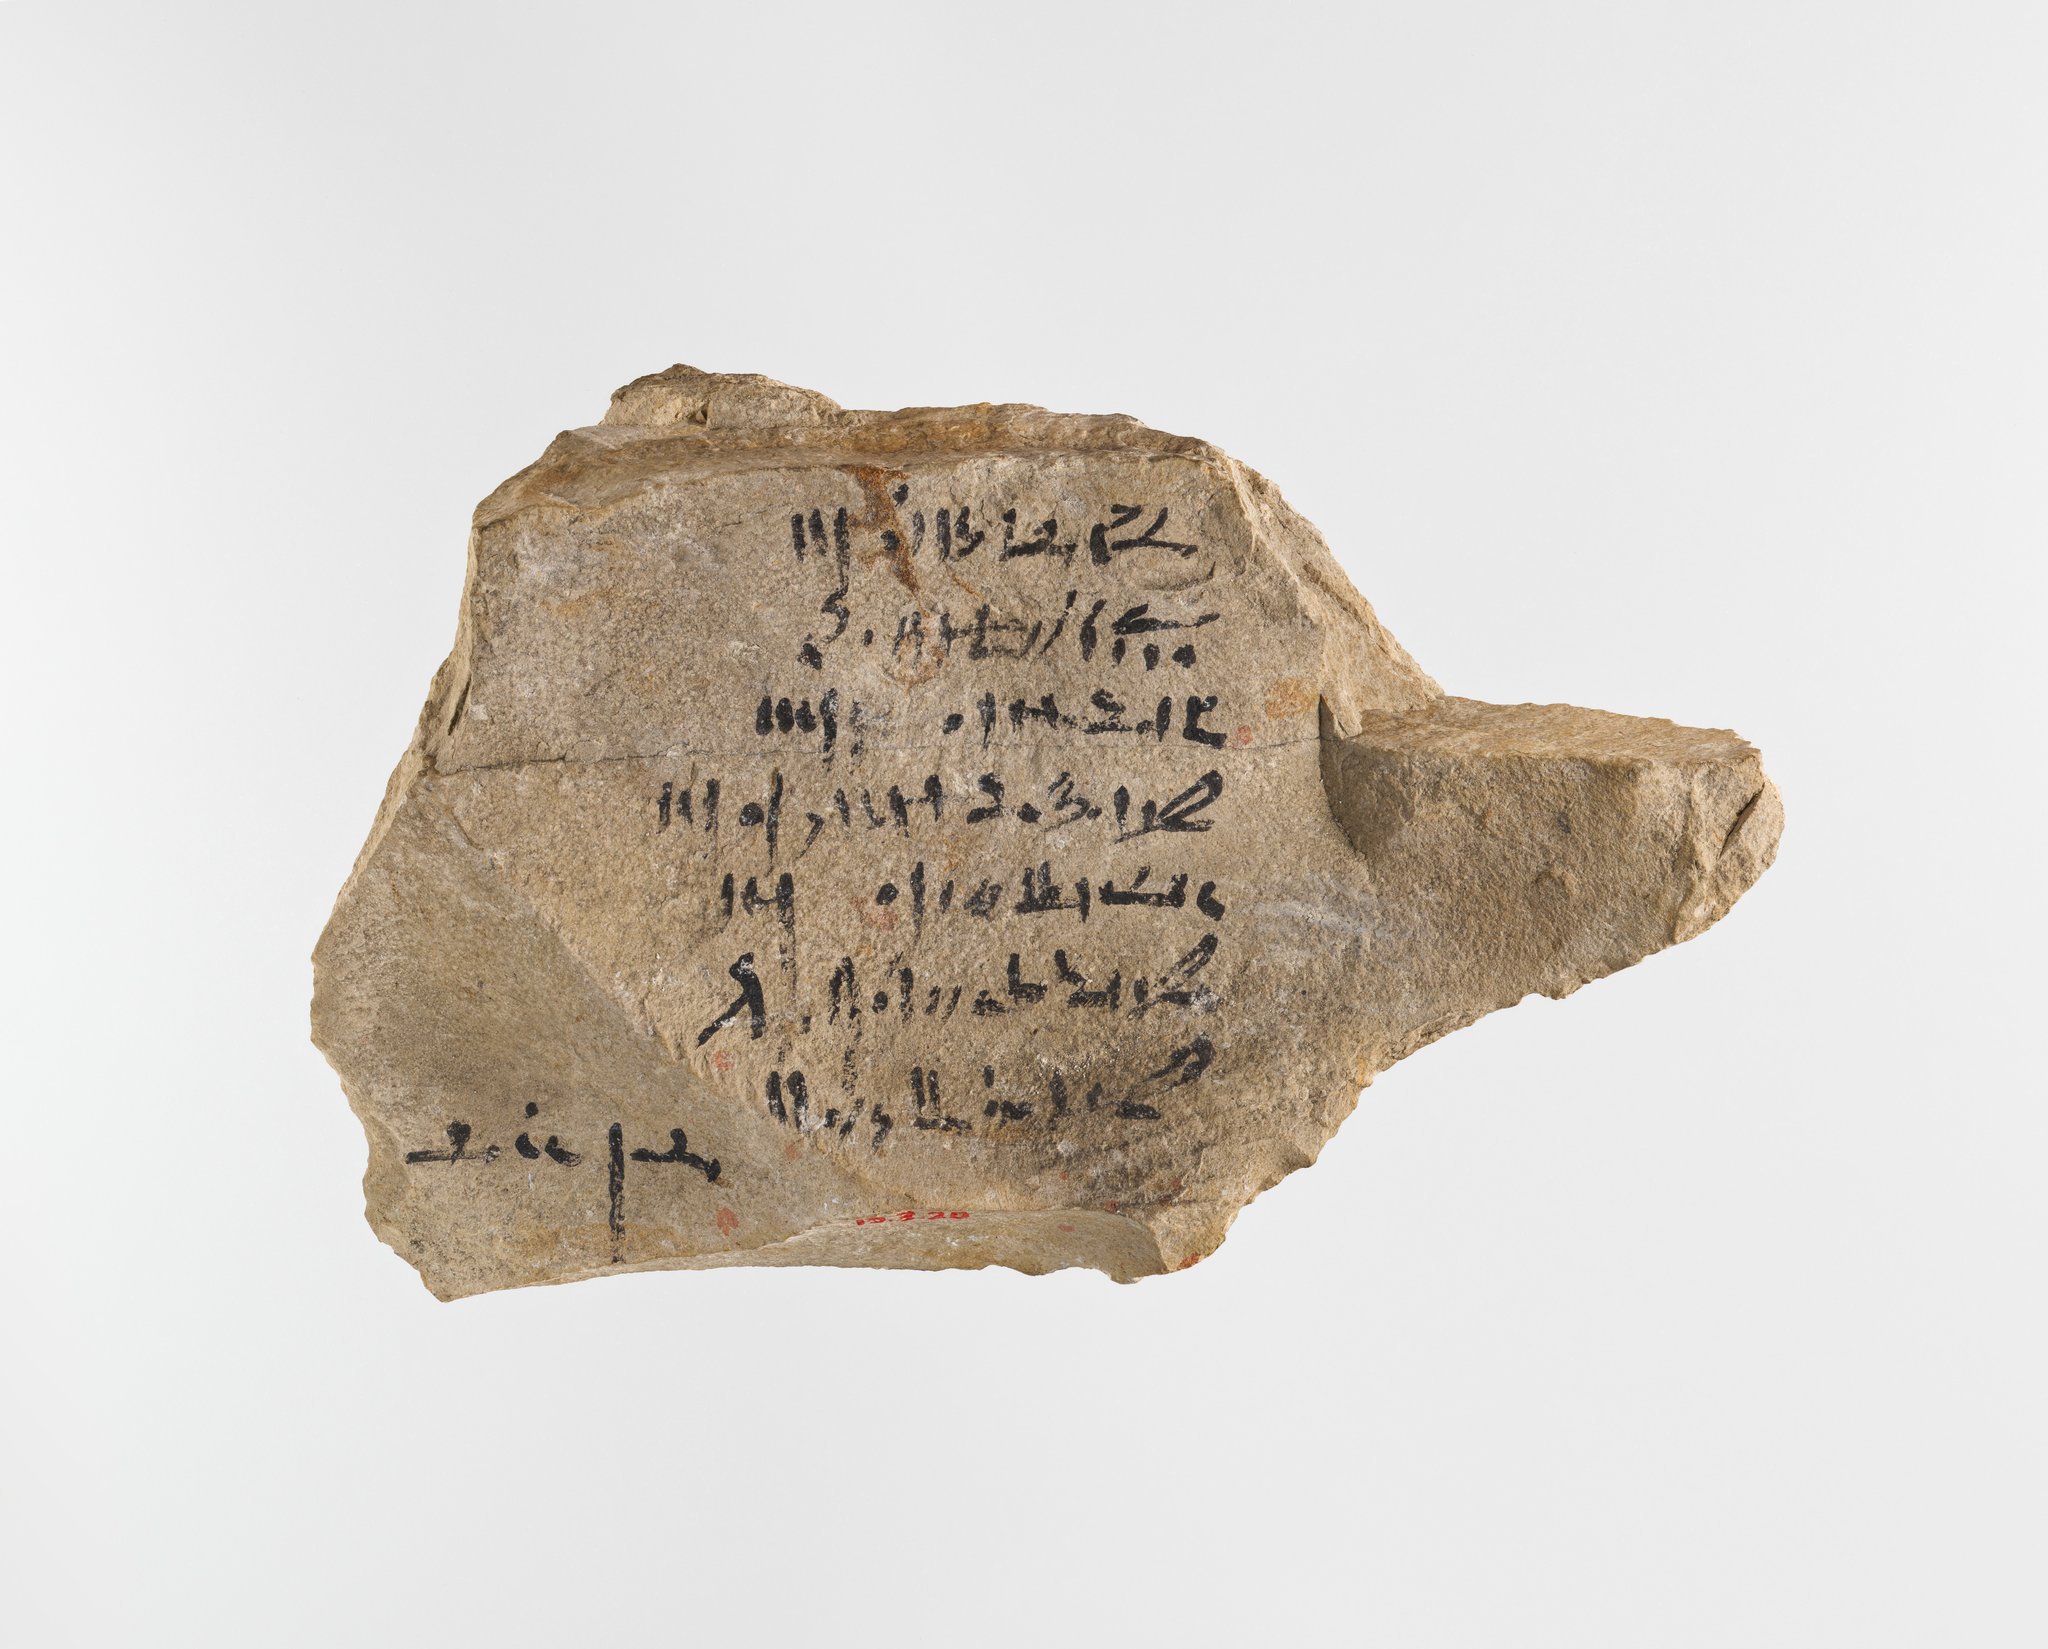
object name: ostracon, hieratic, account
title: Ostracon with hieratic inscription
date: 1295-525 BCE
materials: ink, limestone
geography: egypt